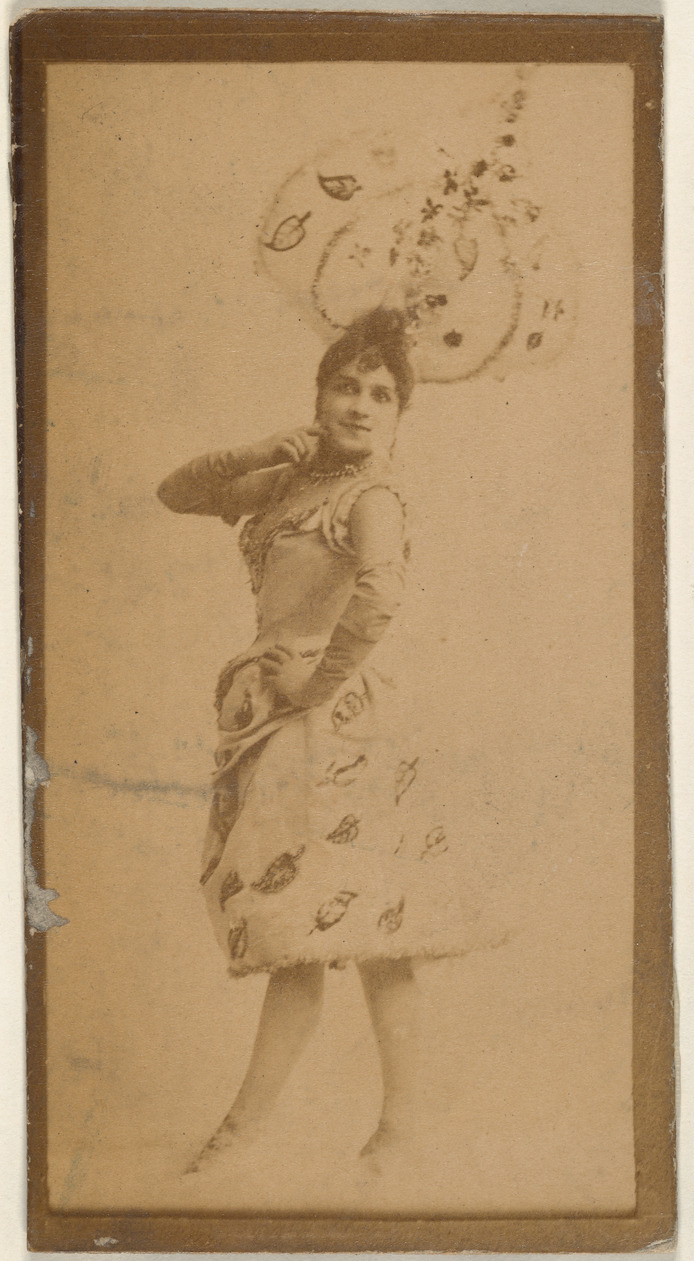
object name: photograph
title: Actress wearing costume with elaborate headpiece, from the Actresses series (N668)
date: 1888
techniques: albumen silver print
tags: portraits,women,actresses